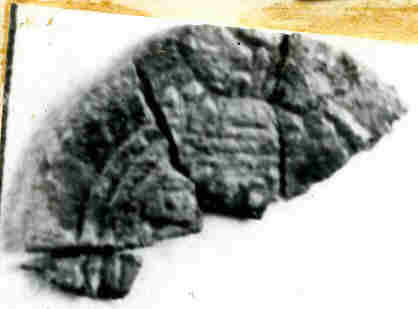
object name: coin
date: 590-628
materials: silver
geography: iran